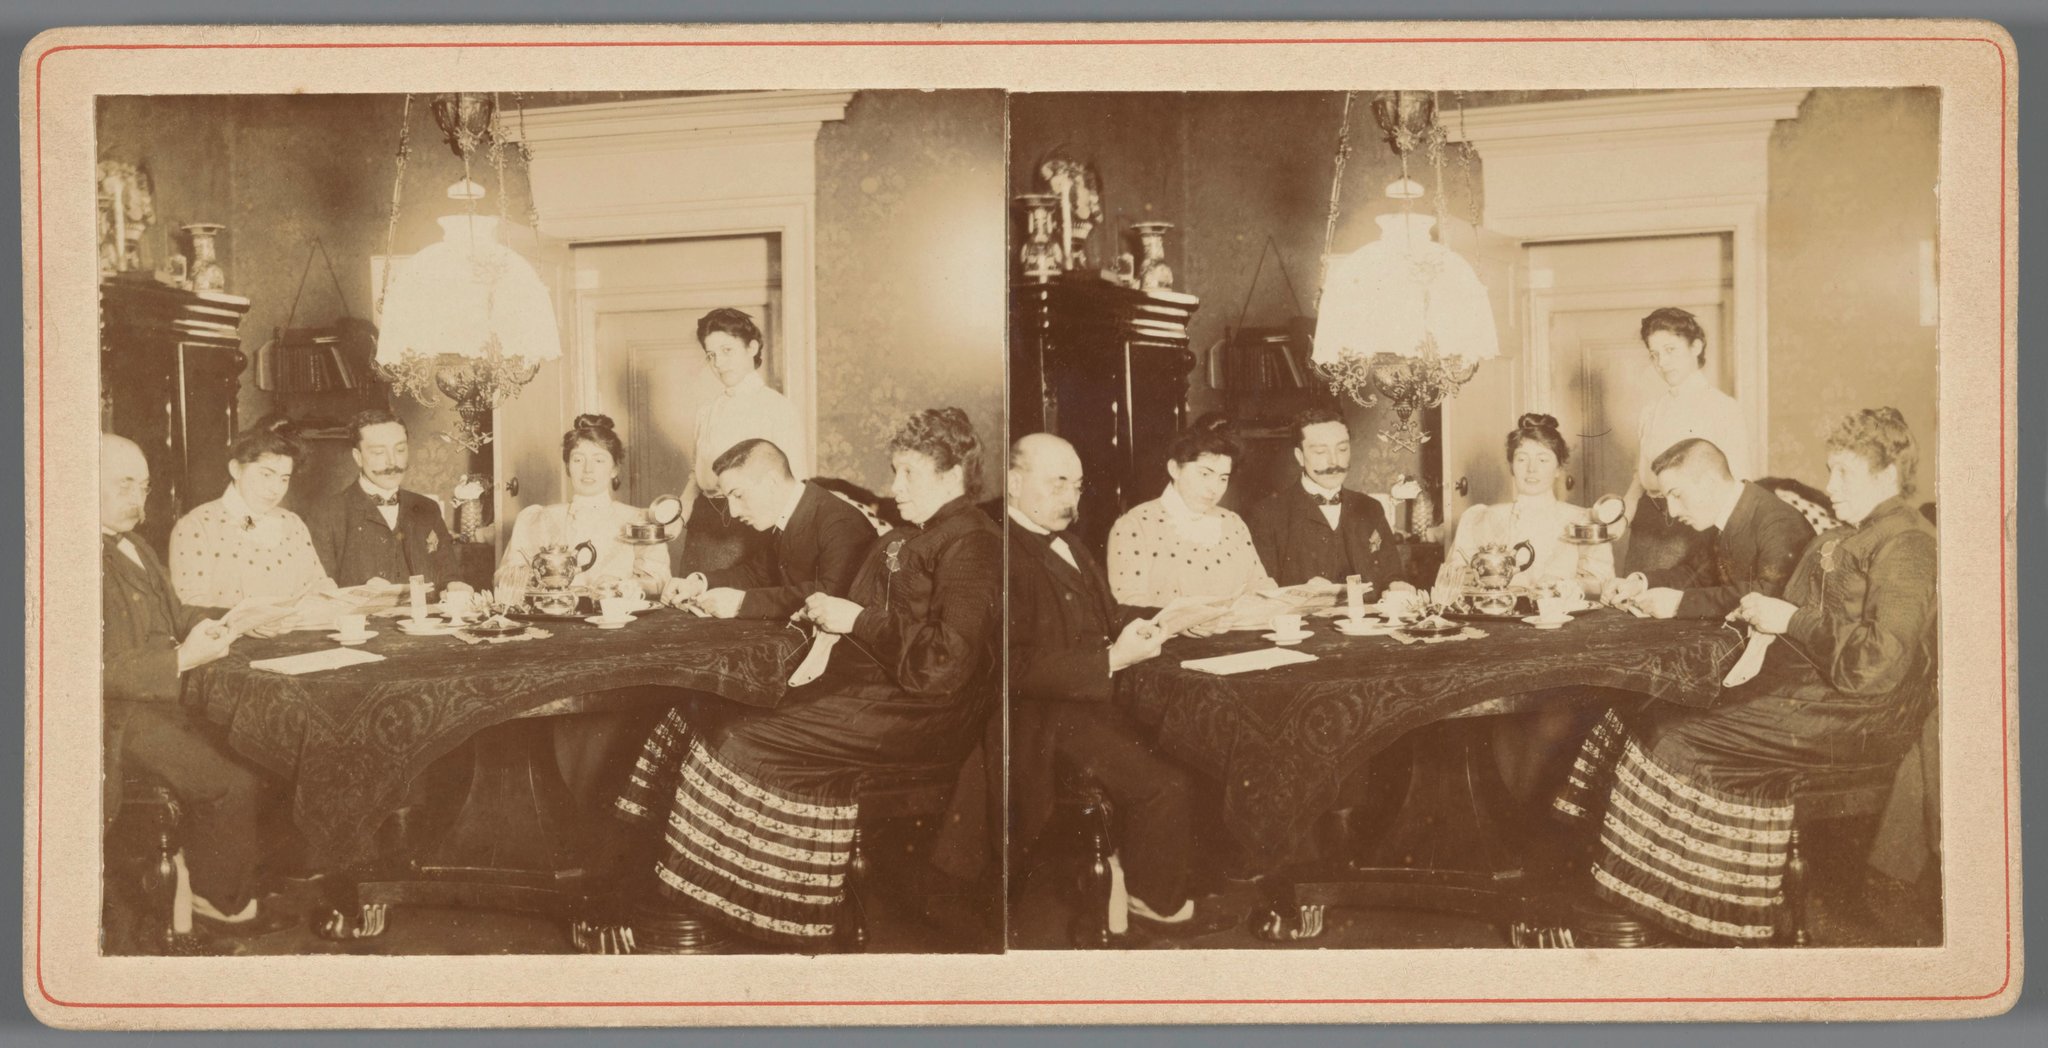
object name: stereograph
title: Gezelschap rond een tafel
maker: Anonymous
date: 1900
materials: cardboard, photographic support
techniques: gelatin silver print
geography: netherlands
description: Interieur met een gezelschap van zeven personen rond een tafel. Onderdeel van een groep van 5 foto's en 19 stereofoto's gemaakt door een onbekende amateurfotograaf rond 1900 in Amsterdam, de Ardennen en Denemarken.